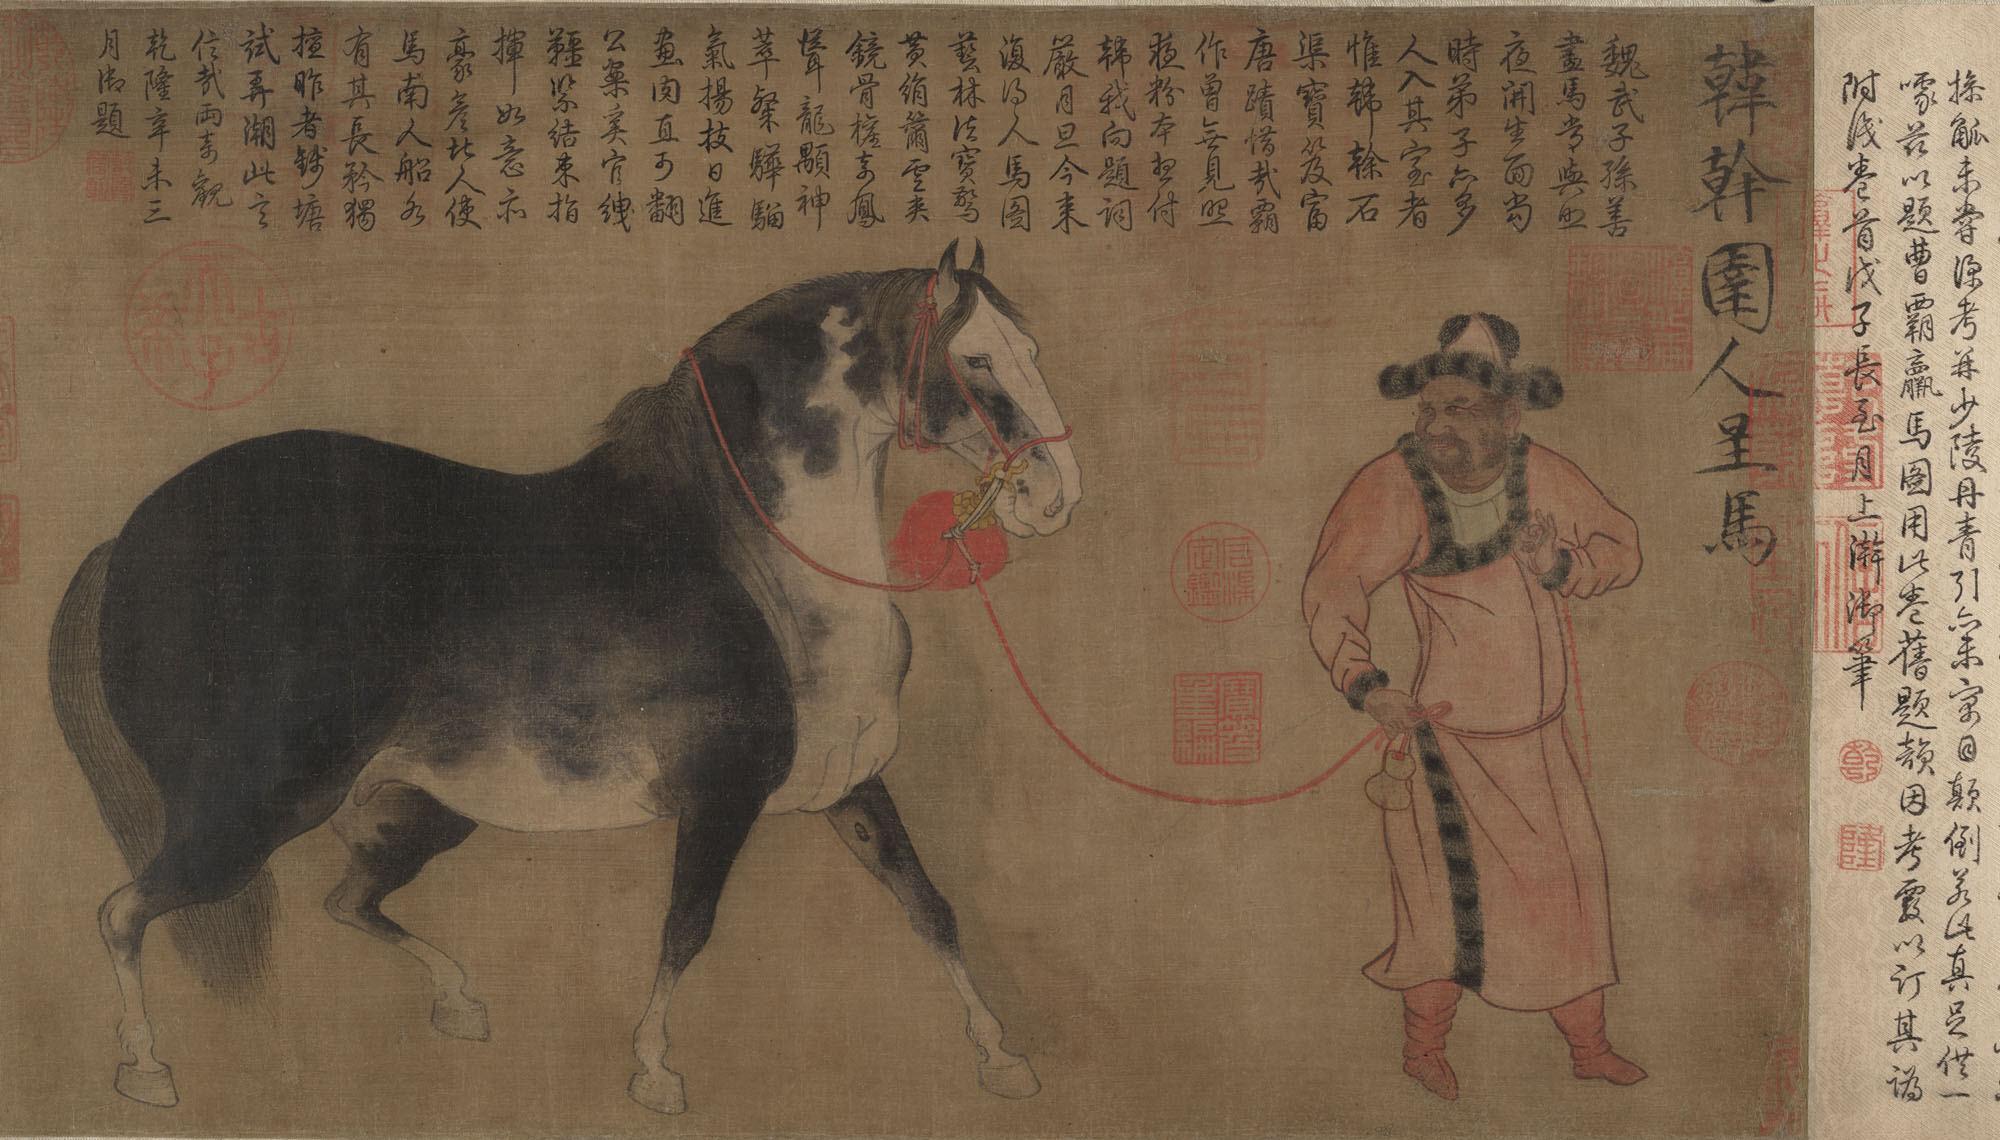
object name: handscroll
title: Horse and groom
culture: chinese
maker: unidentified artist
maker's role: artist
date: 1501-1600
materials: ink, silk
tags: men,horses